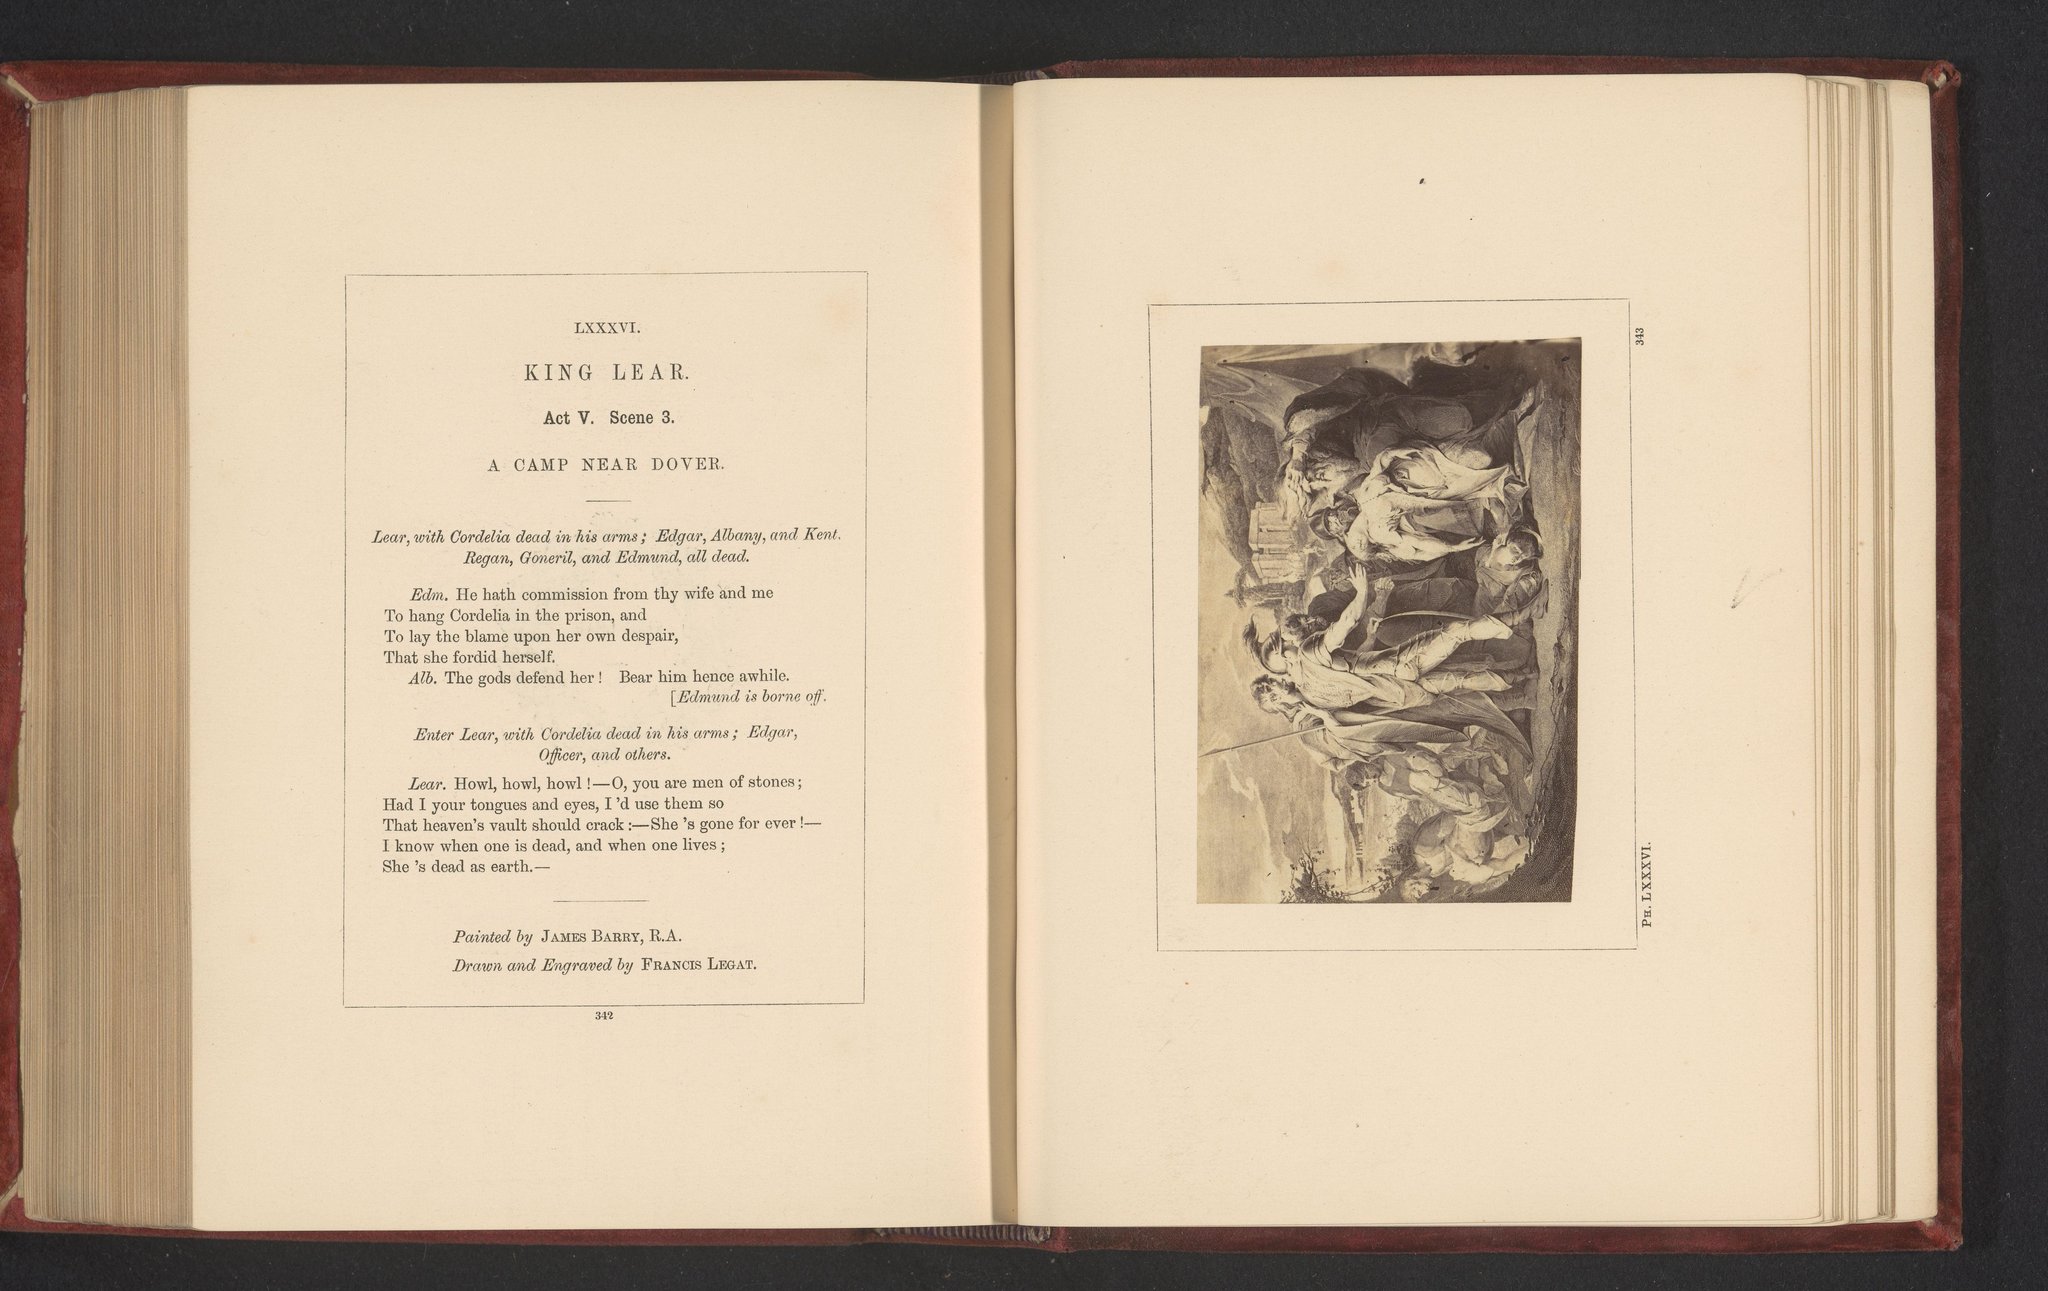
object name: page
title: Fotoreproductie van een prent naar een schilderij door James Barry, voorstellend een scene uit Koning Lear door William Shakespeare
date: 1854-1864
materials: photographic support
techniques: albumen print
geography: london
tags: king lear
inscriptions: number: ‘Ph. LXXXVI. 343’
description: Te zien is akte V, scene 3 met koning Lear met het dode lichaam van Cordelia in zijn handen.